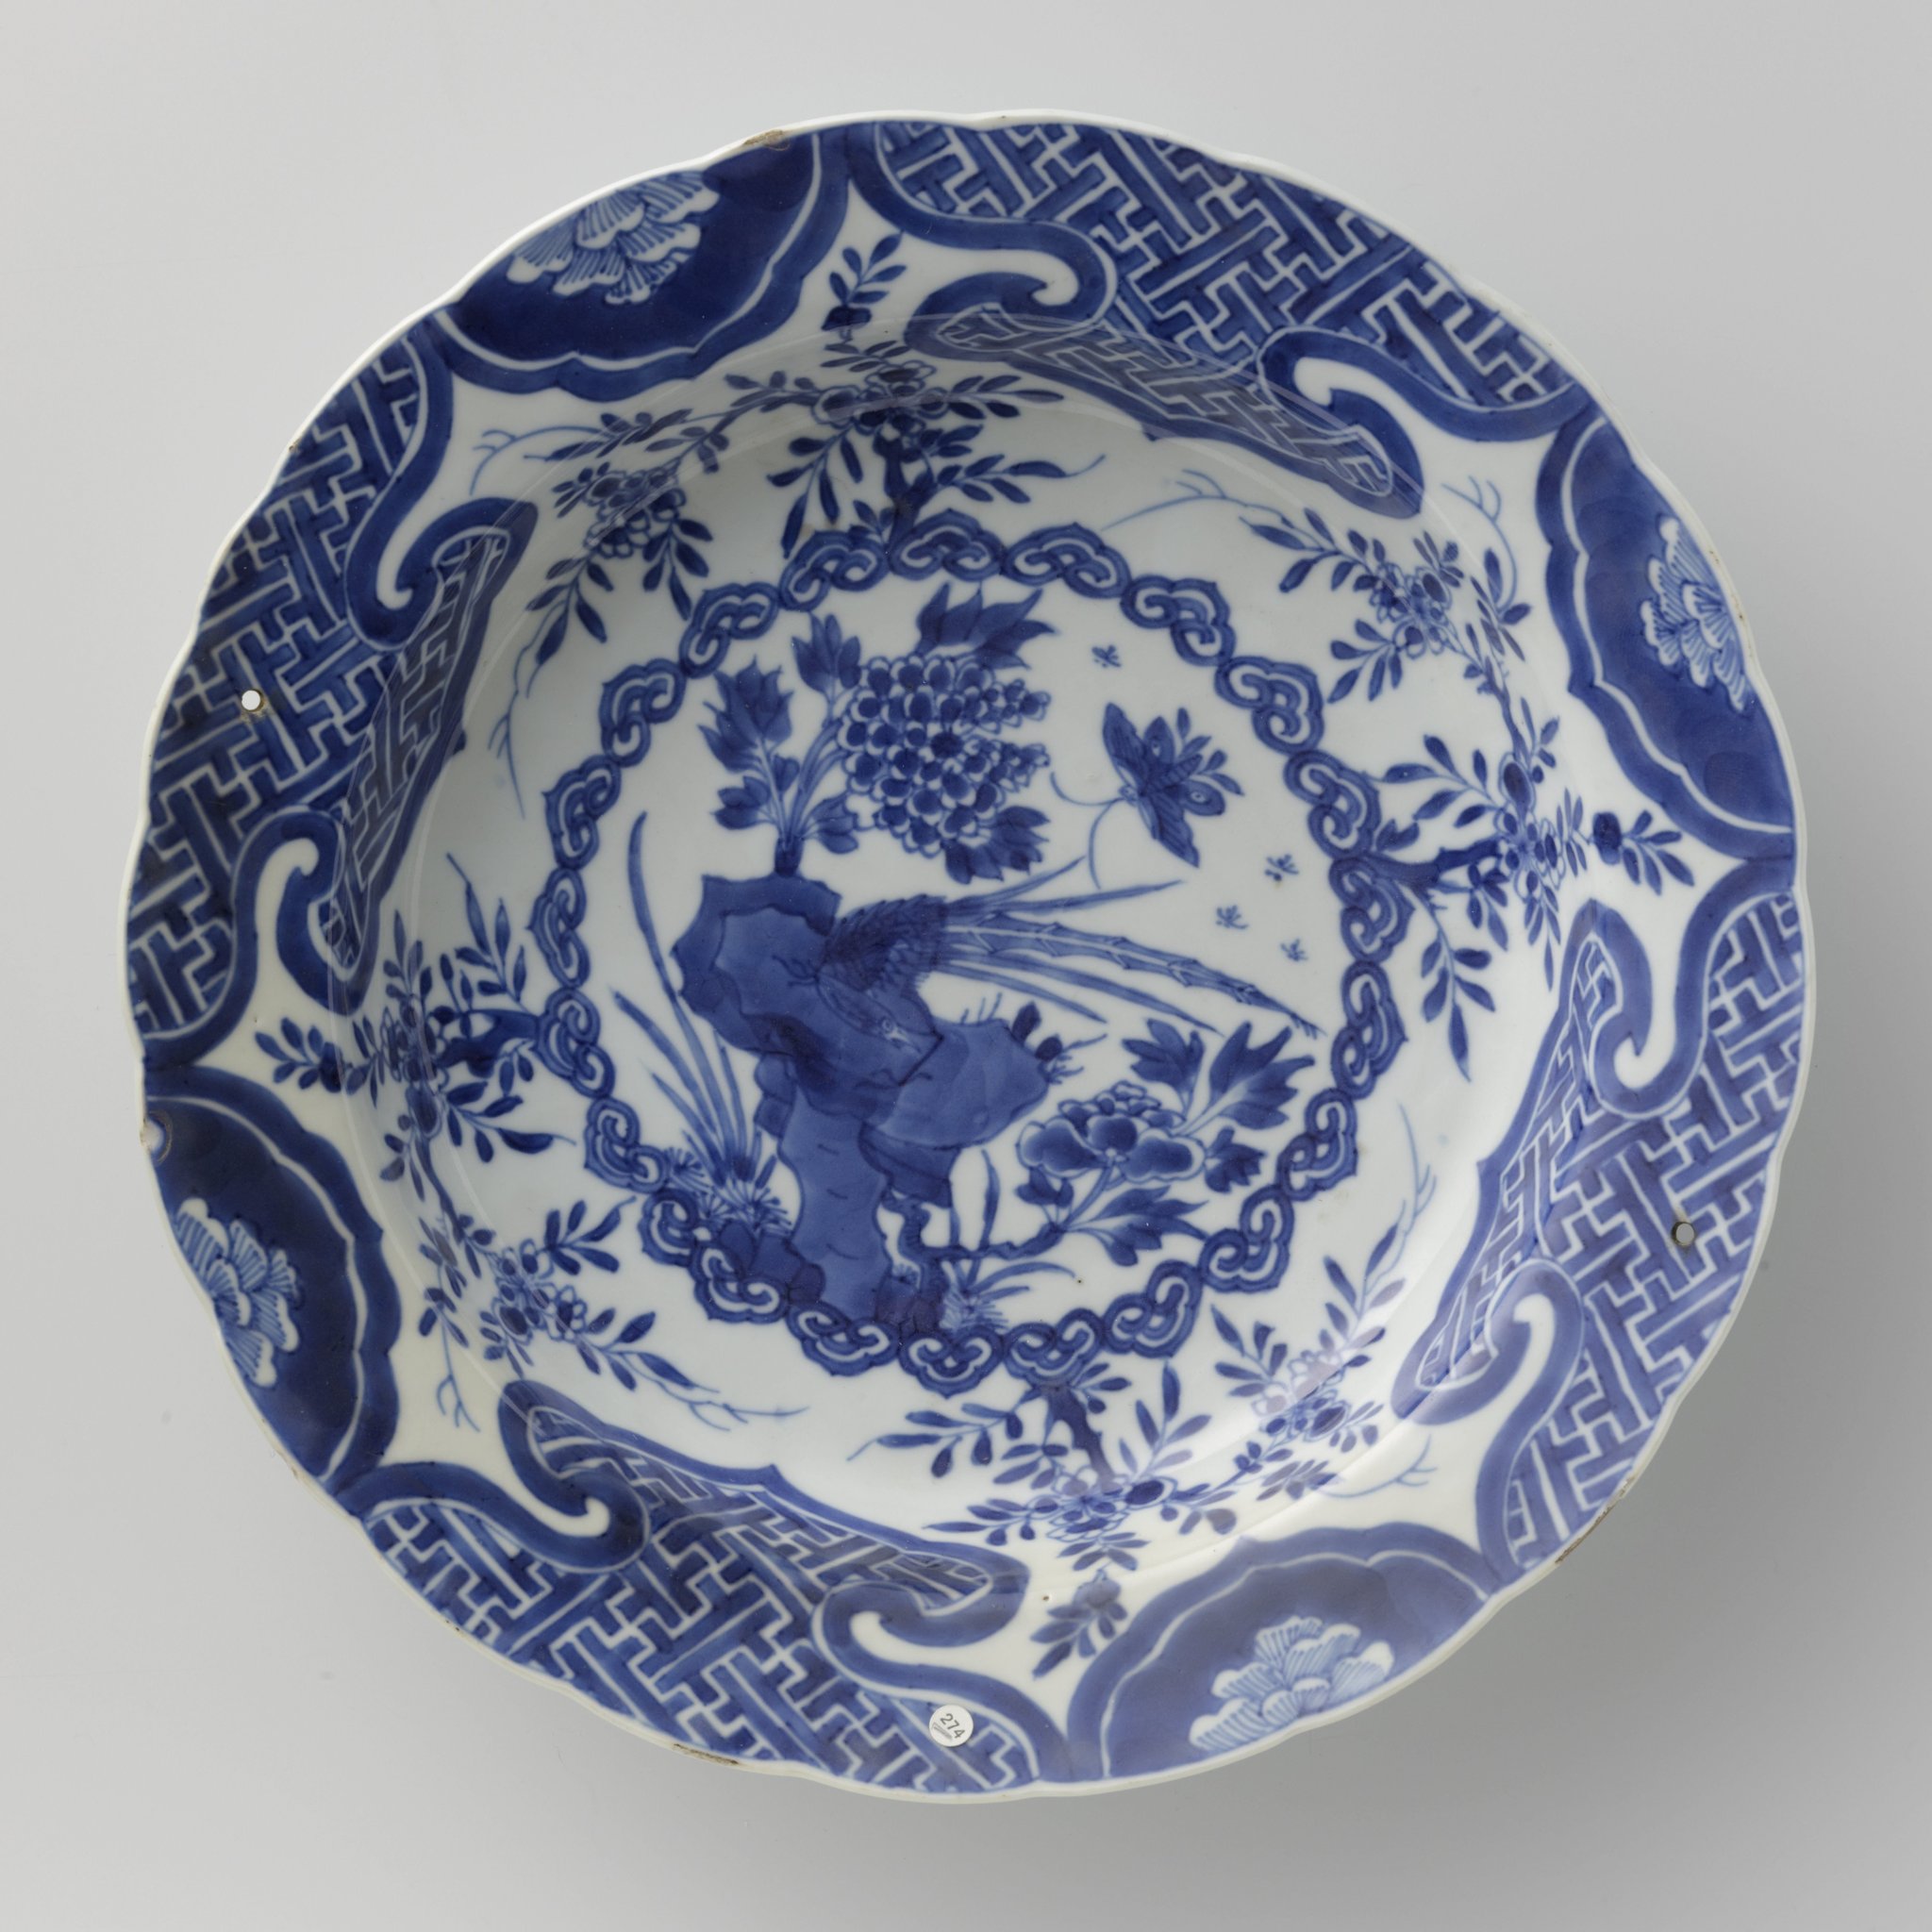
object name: platter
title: Dish with a pheasant on a rock, butterfly and flower sprays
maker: Anonymous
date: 1680-1720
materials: cobalt, glaze, paint, porcelain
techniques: firing, turning, vitrification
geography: china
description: Bord, op het plat bloeiende struiken en een rots met rand van jui-motieven.